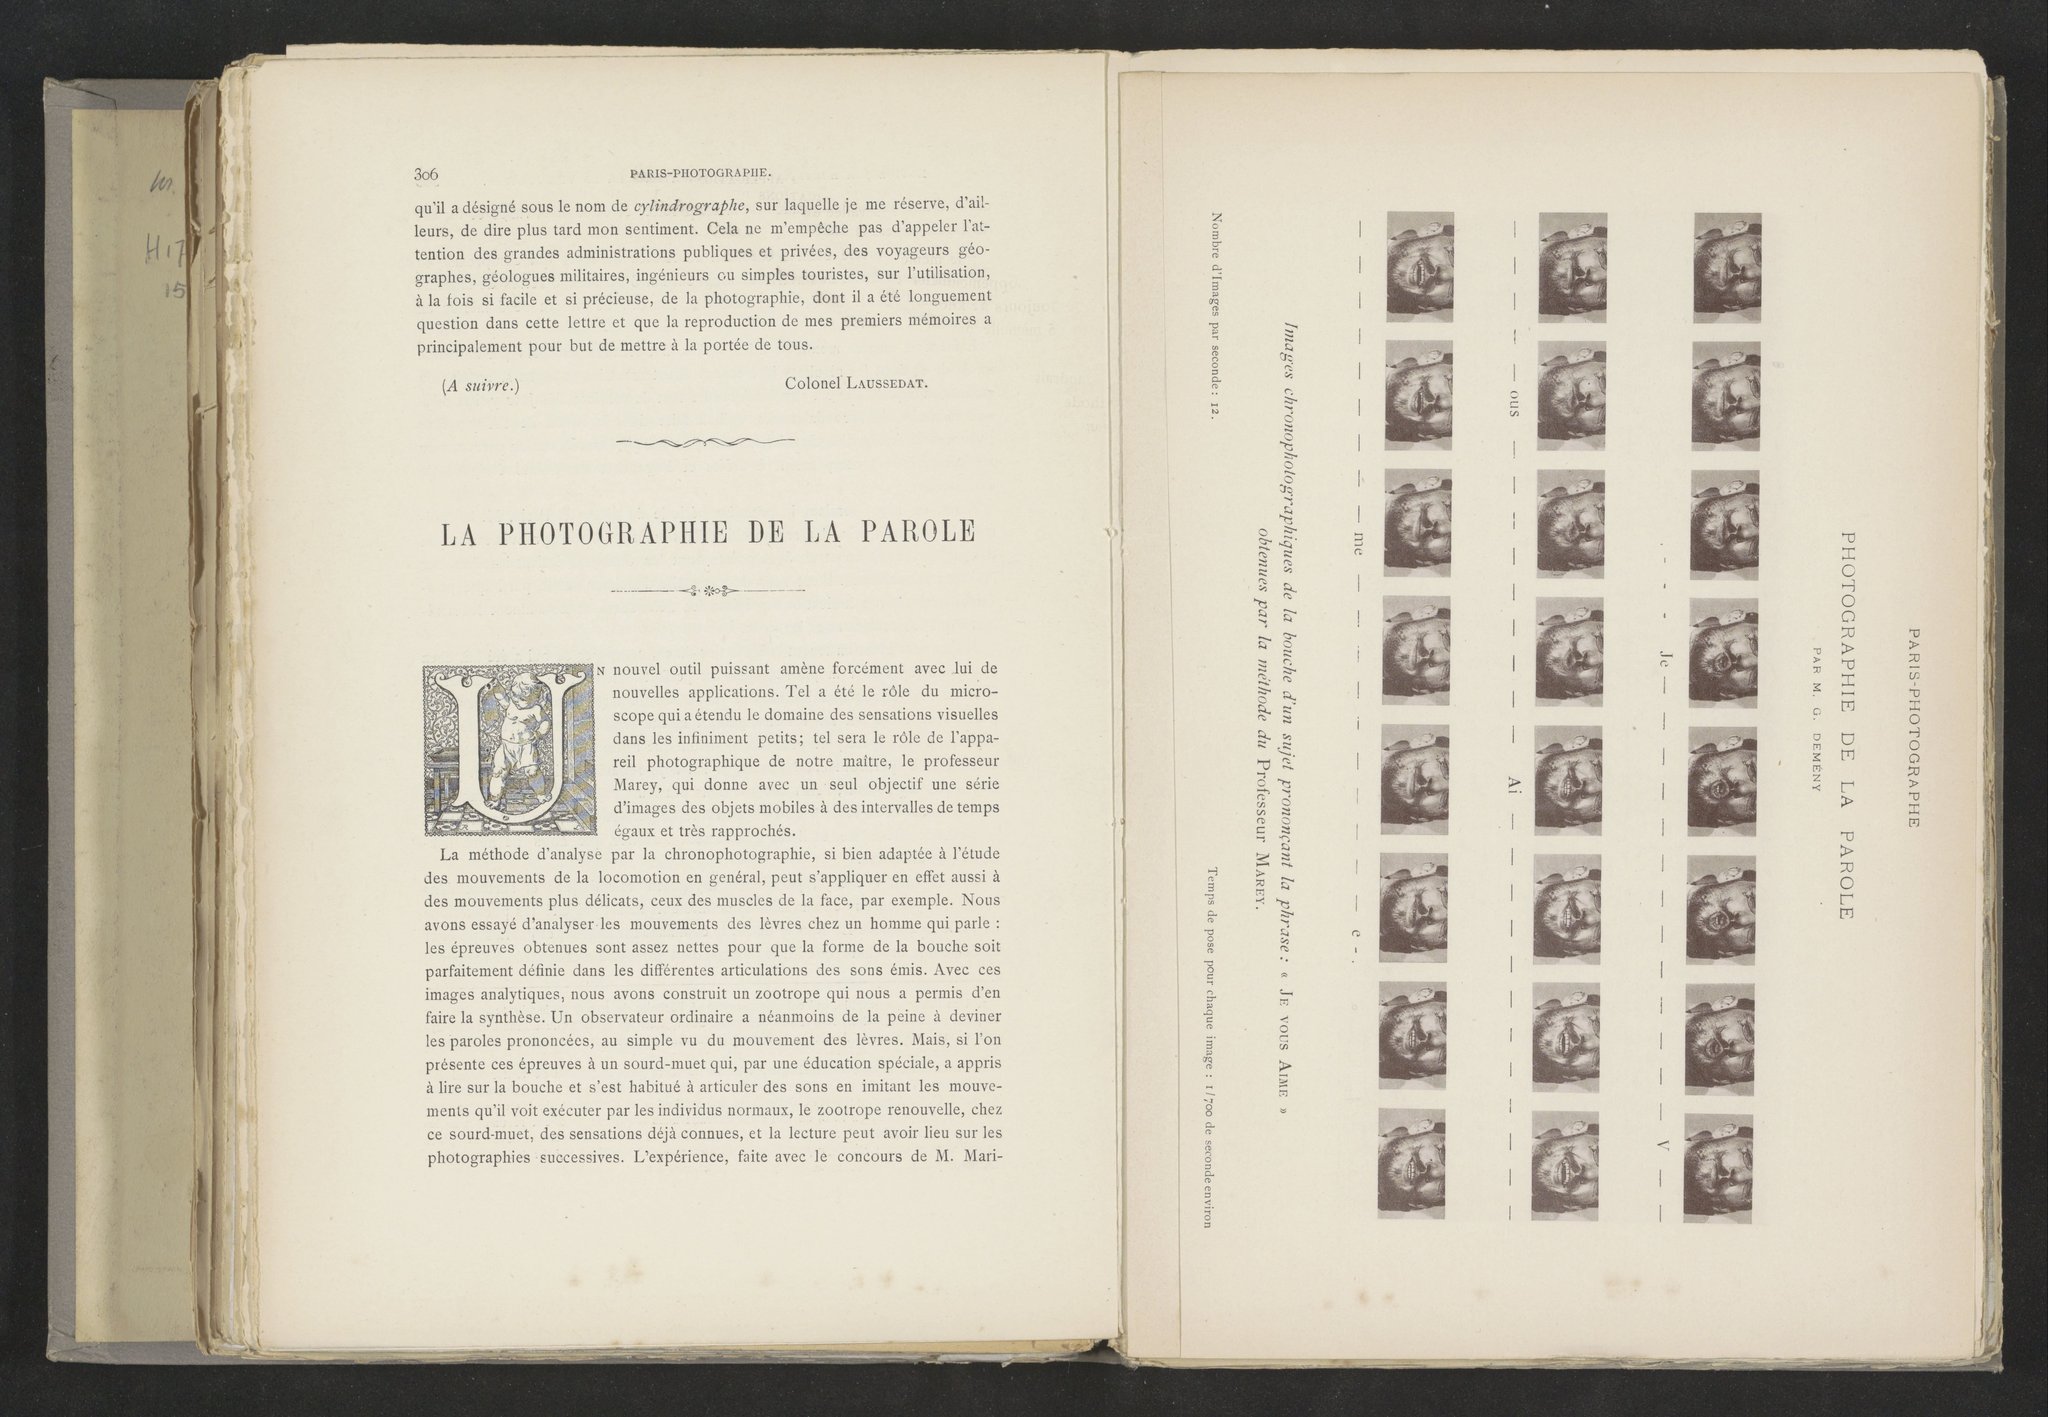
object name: page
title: Sequence of the Mouth Pronouncing the Sentence ‘Je vous aime’ (I love you)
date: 1891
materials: paper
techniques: photograph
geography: france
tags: speaking, mouth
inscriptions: inscription: ‘Nombre d'Images par seconde: 12. Temps de pose pour chaque image: 1/700 de seconde environ’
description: Are these photographs or film footage? The line is blurred in this series of shots taken by Demenÿ in 1891. In the 24 images, he photographed or filmed himself uttering the words ‘Je vous aime’ (I love you). It takes about two seconds to make such a sequence. Demenÿ’s experiments were intended to teach people with auditory impairment how to read lips.